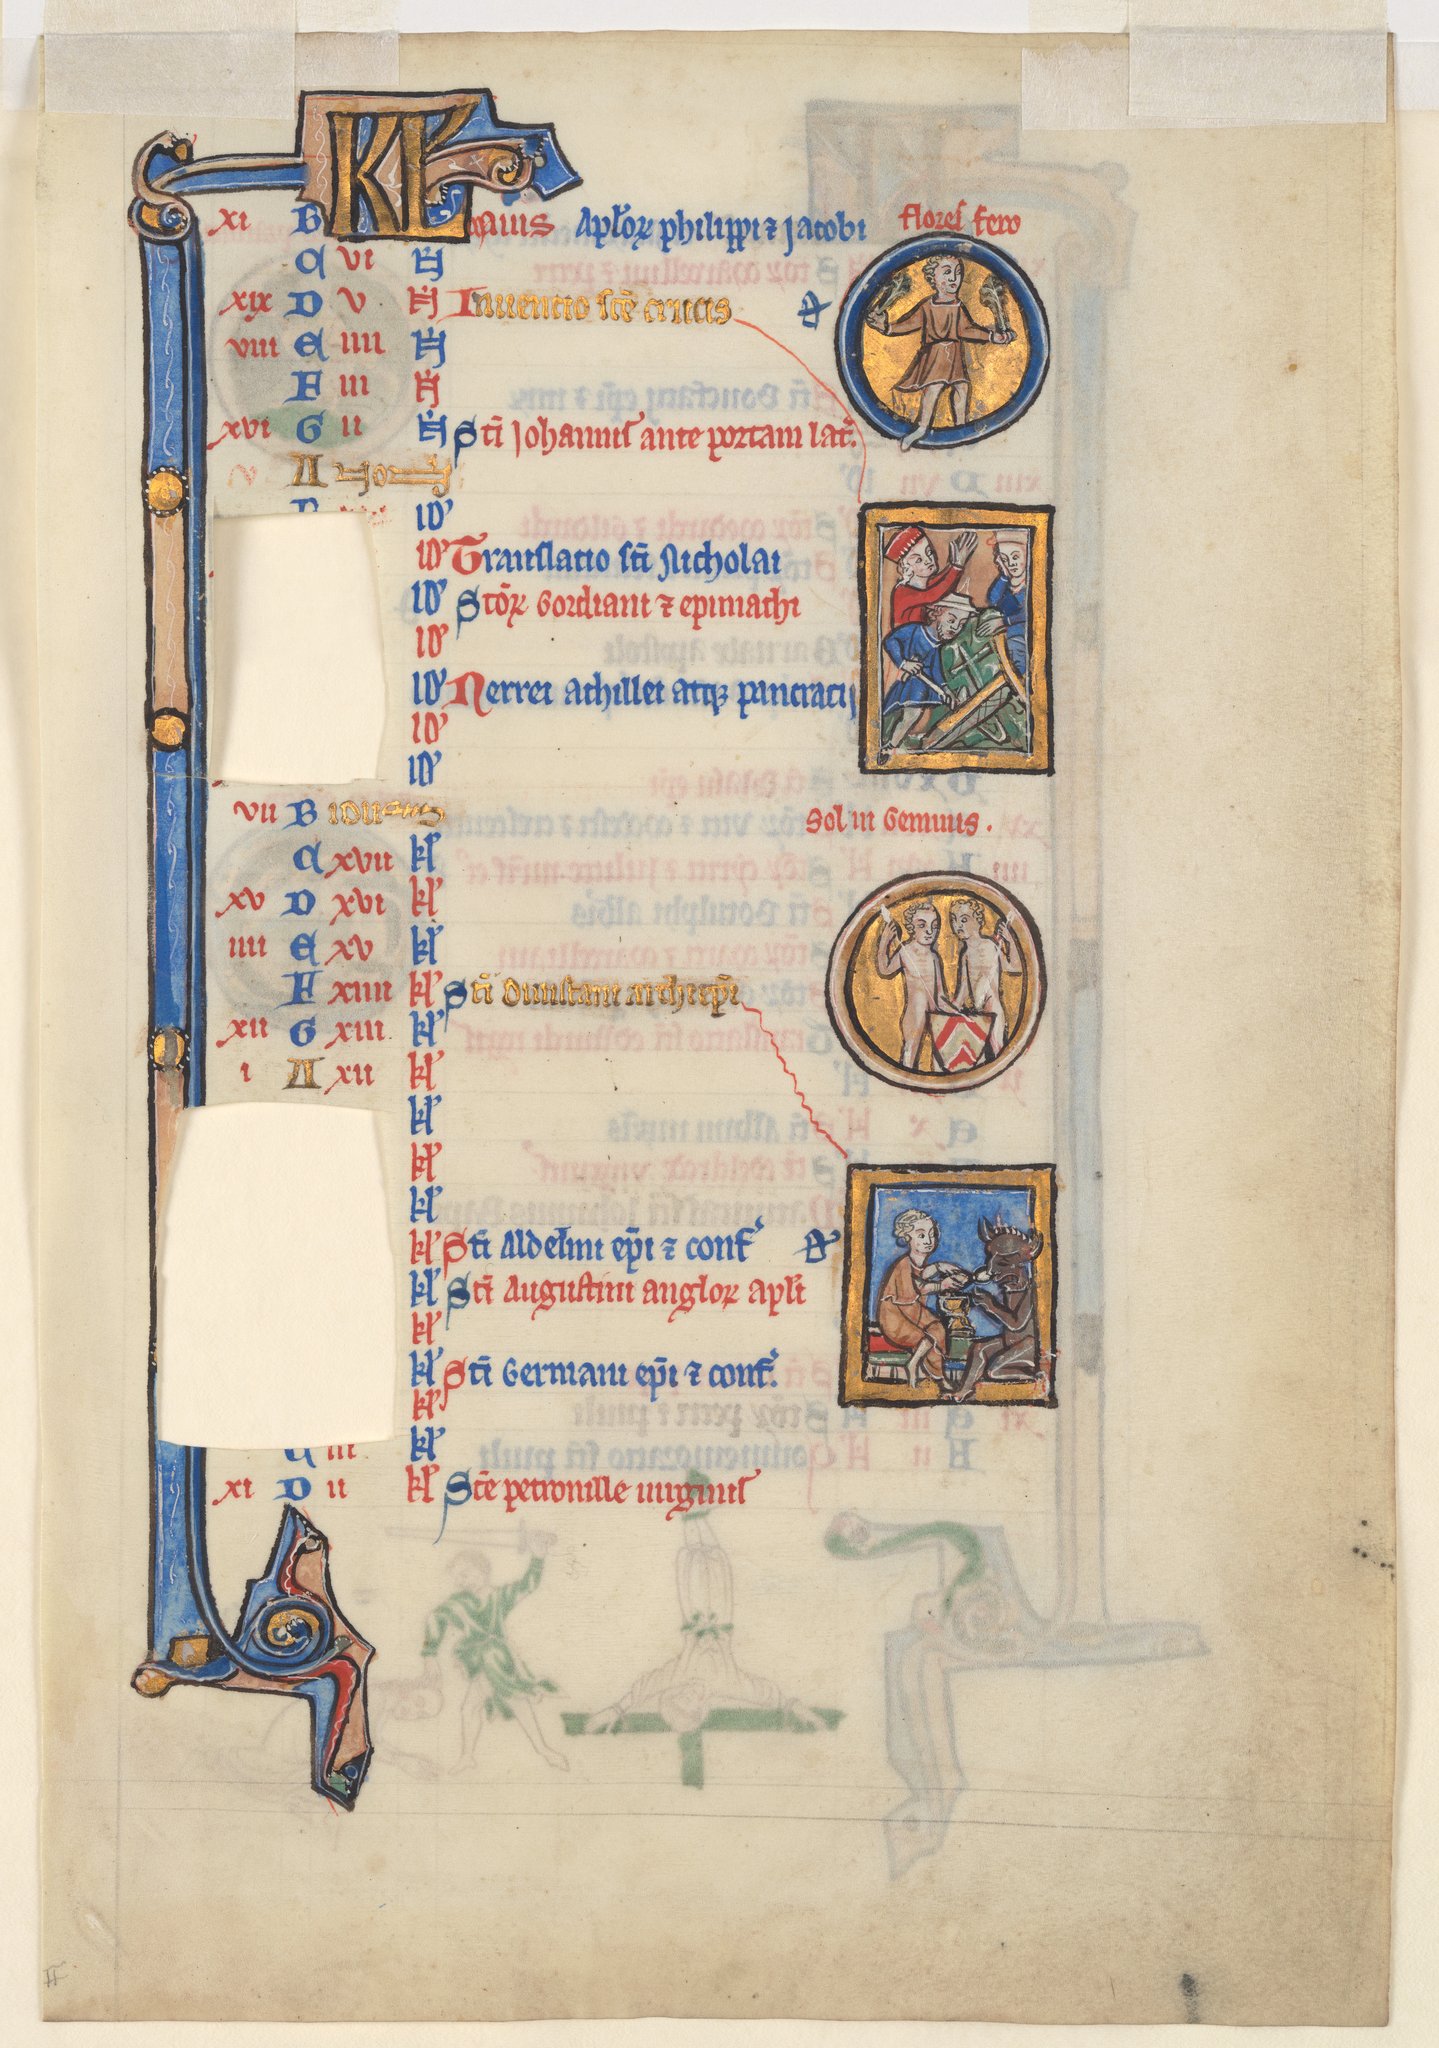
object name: psalter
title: Manuscript Leaf with June Calendar, from a Royal Psalter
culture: british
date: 1201-1300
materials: gold, parchment, paint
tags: saint paul,saint peter,zodiac,calendars